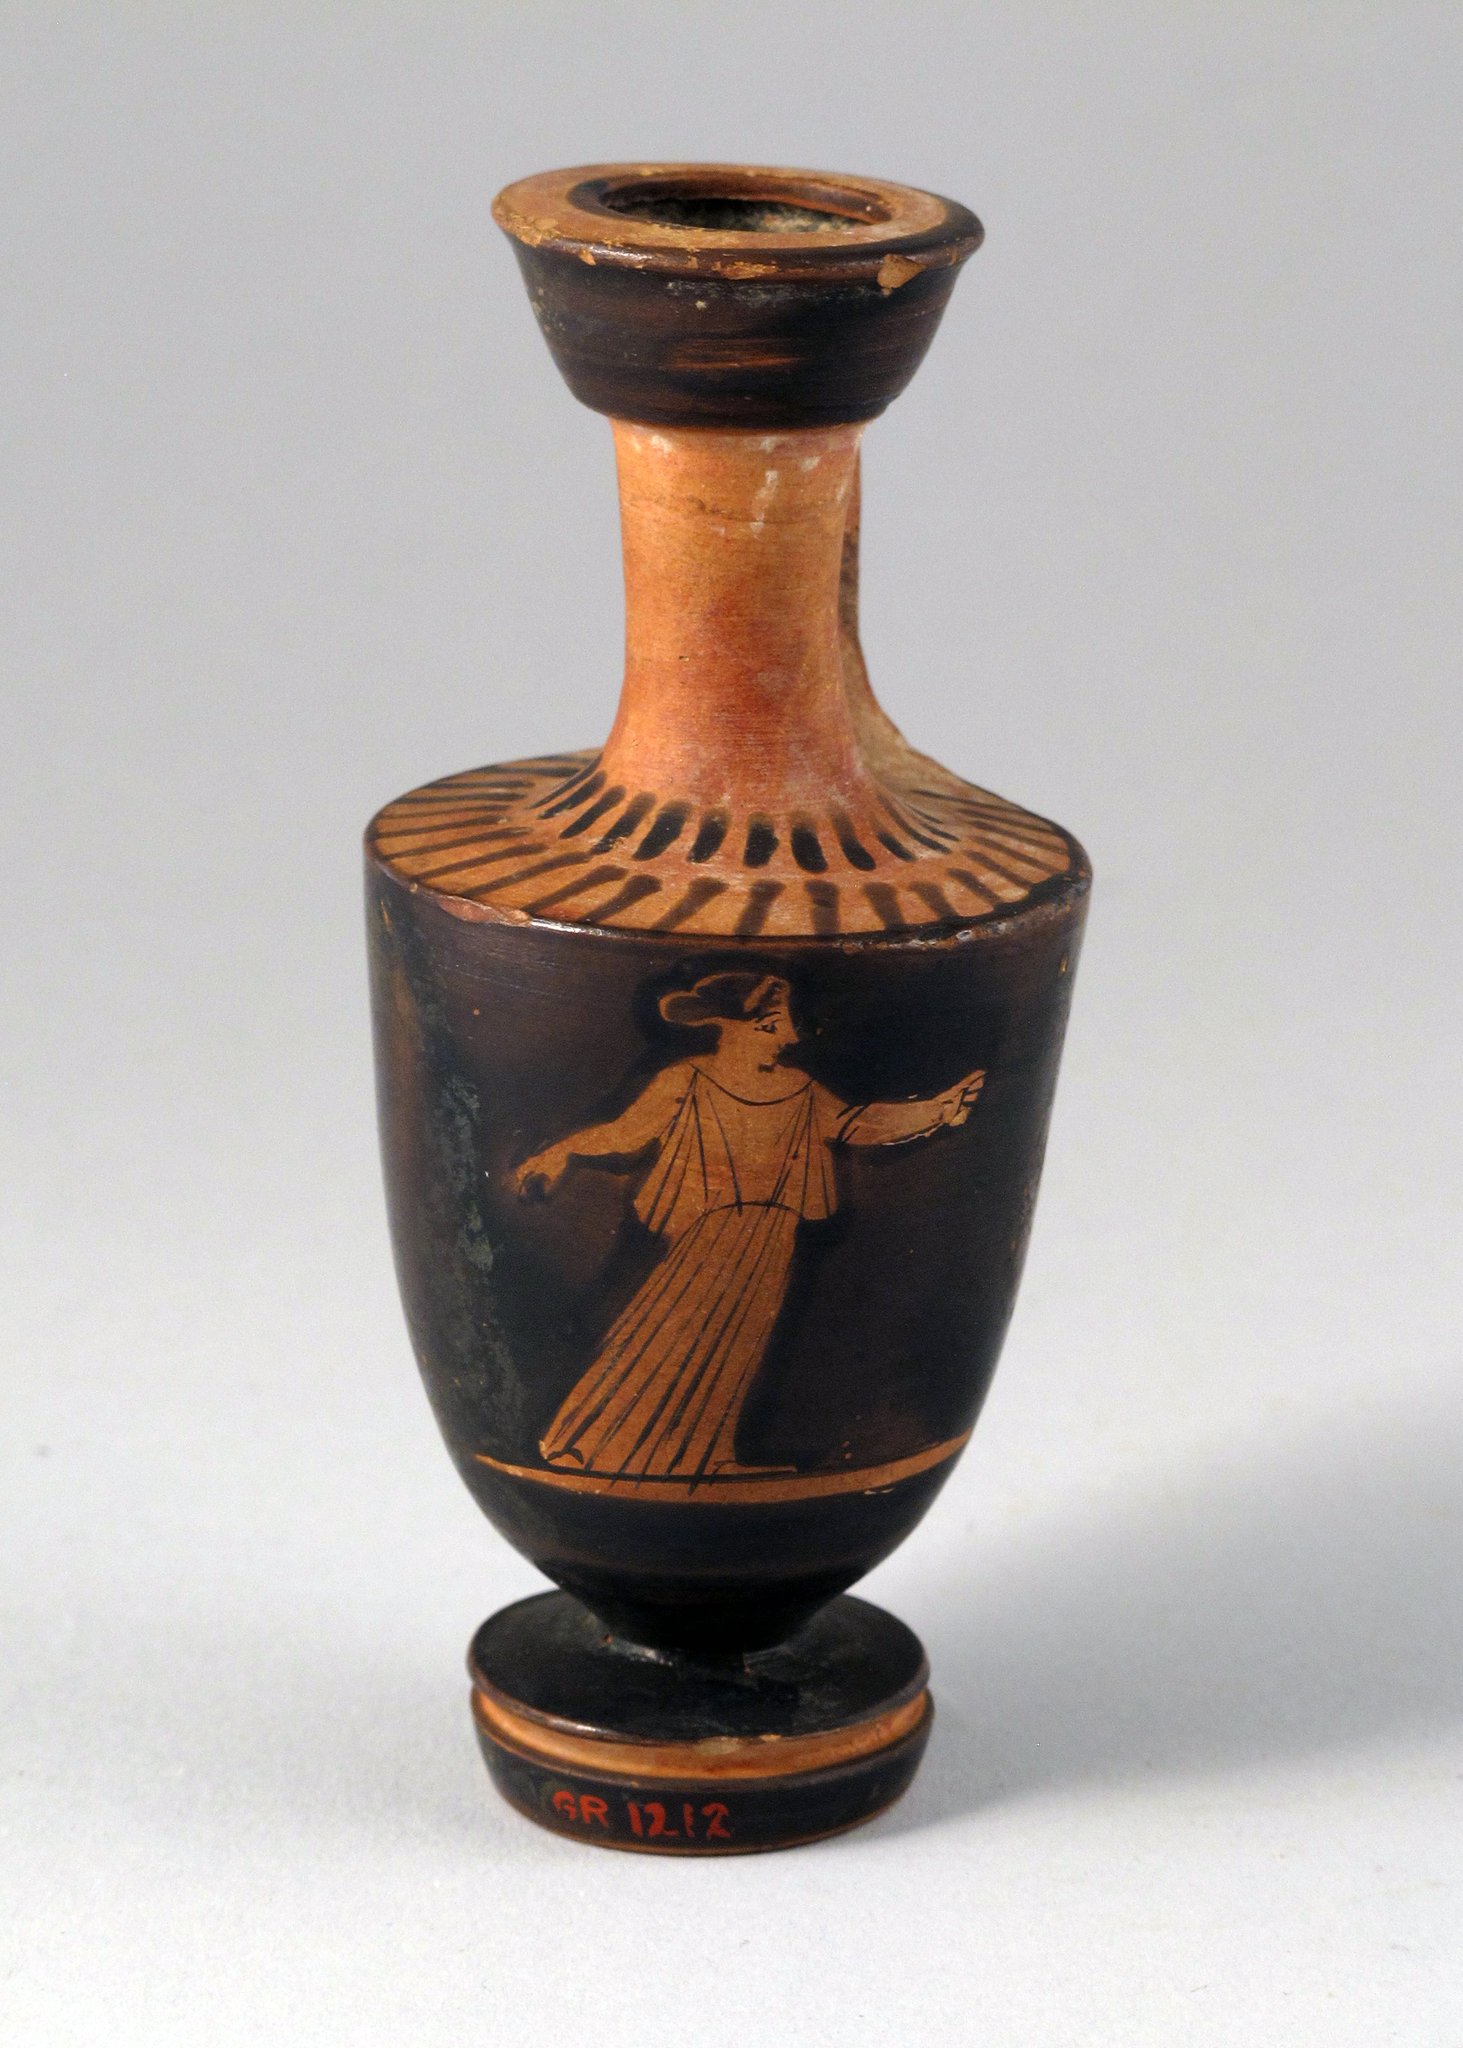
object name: lekythos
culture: greek, attic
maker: group of london e 614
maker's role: artist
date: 434-401 BCE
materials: terracotta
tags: women